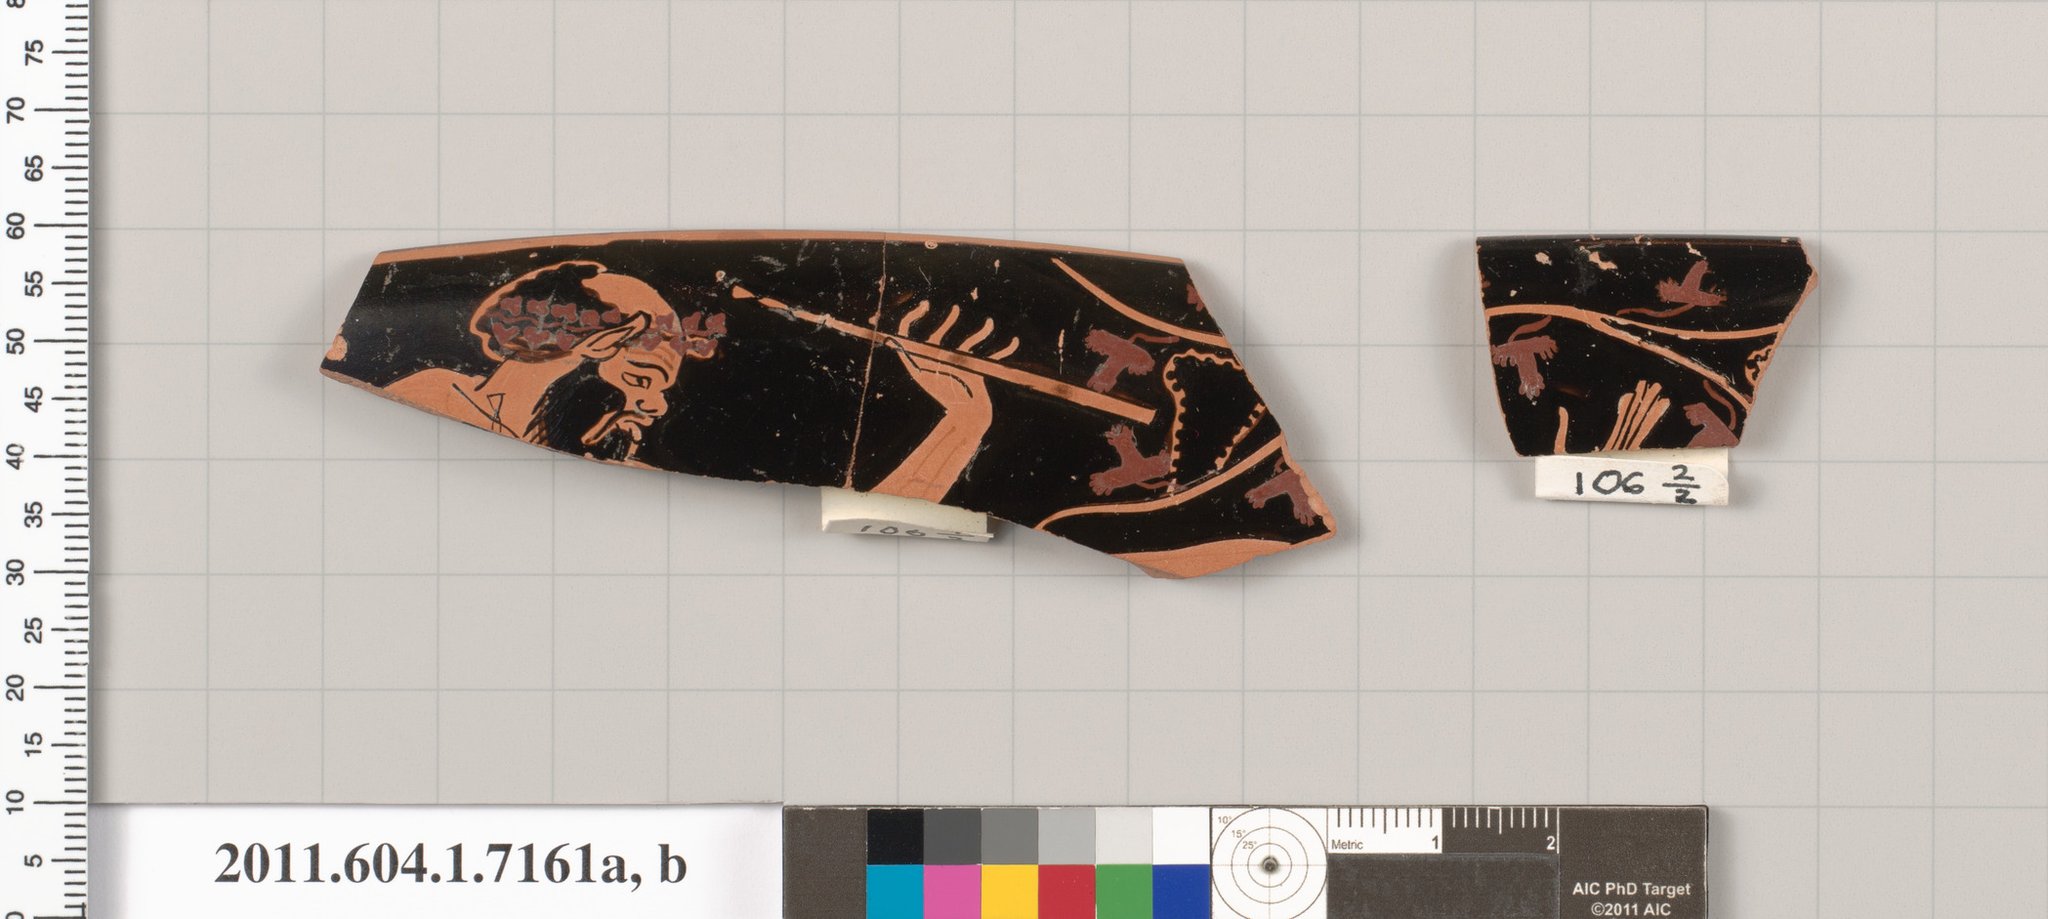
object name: kylix fragment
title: Terracotta rim fragments of a kylix (drinking cup)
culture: greek, attic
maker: makron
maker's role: artist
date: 500-480 BCE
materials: terracotta